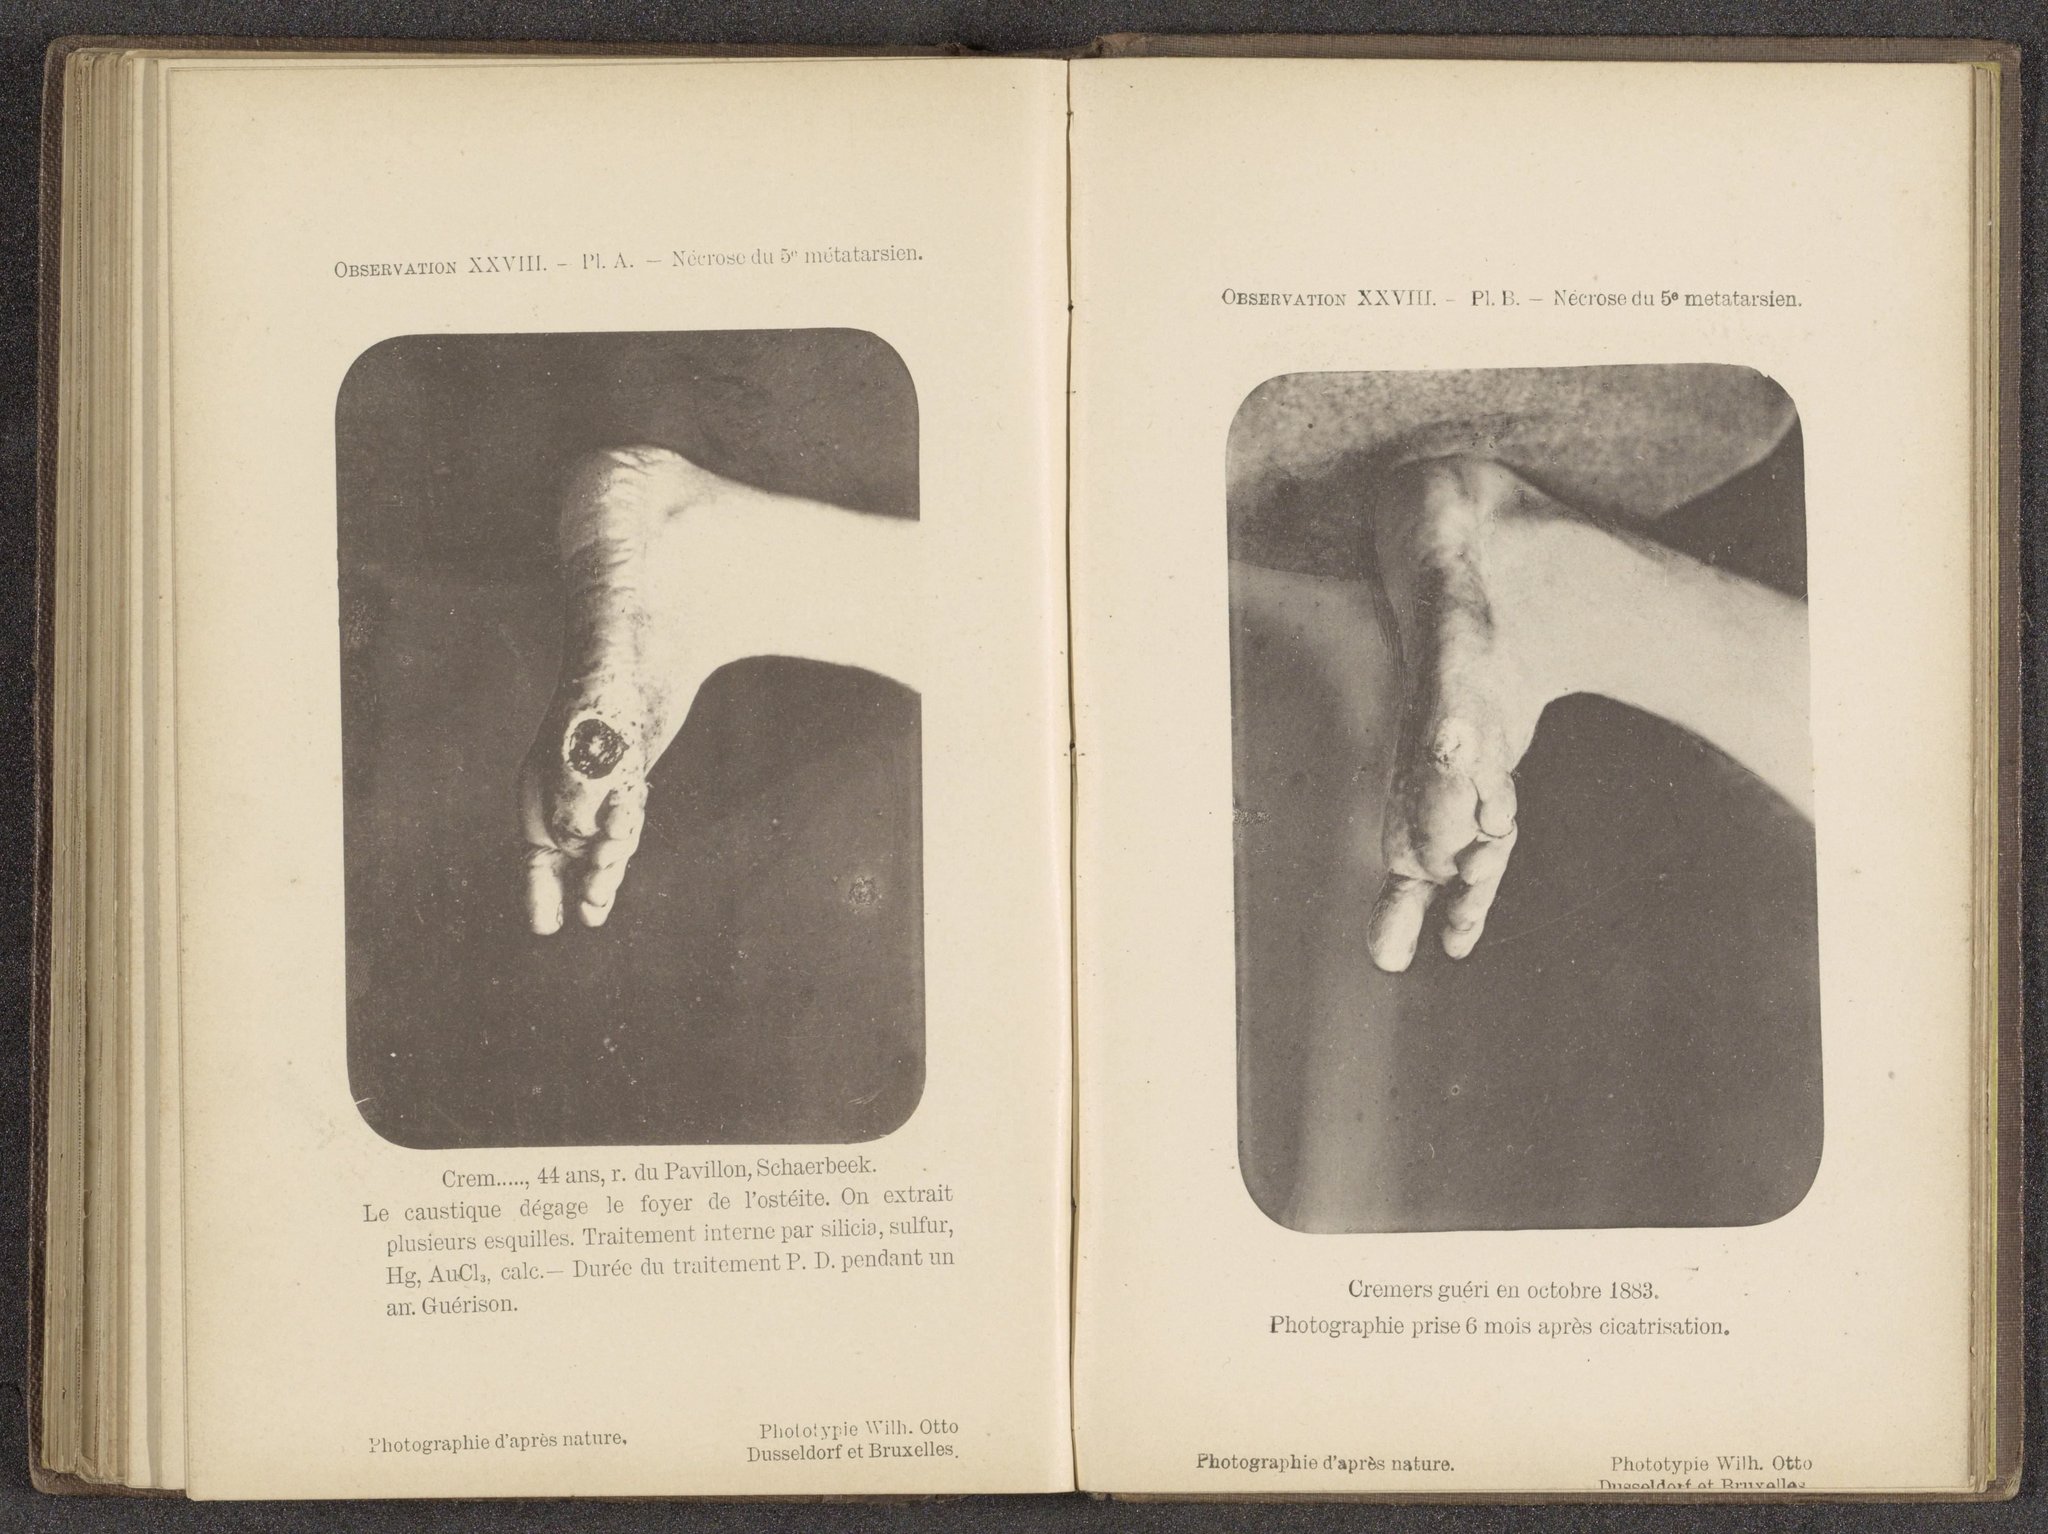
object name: photomechanical print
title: Voet met een necrotische wond aan een middenvoetsbeentje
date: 1874-1884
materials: paper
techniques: photograph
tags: tumours, infections and wounds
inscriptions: inscription: ‘Observation XXVIII. - Pl. A. Nécrose du 5e métatarsien. / Crem....,44 ans, r. du Pavillon, Schaerbeek. (...)’